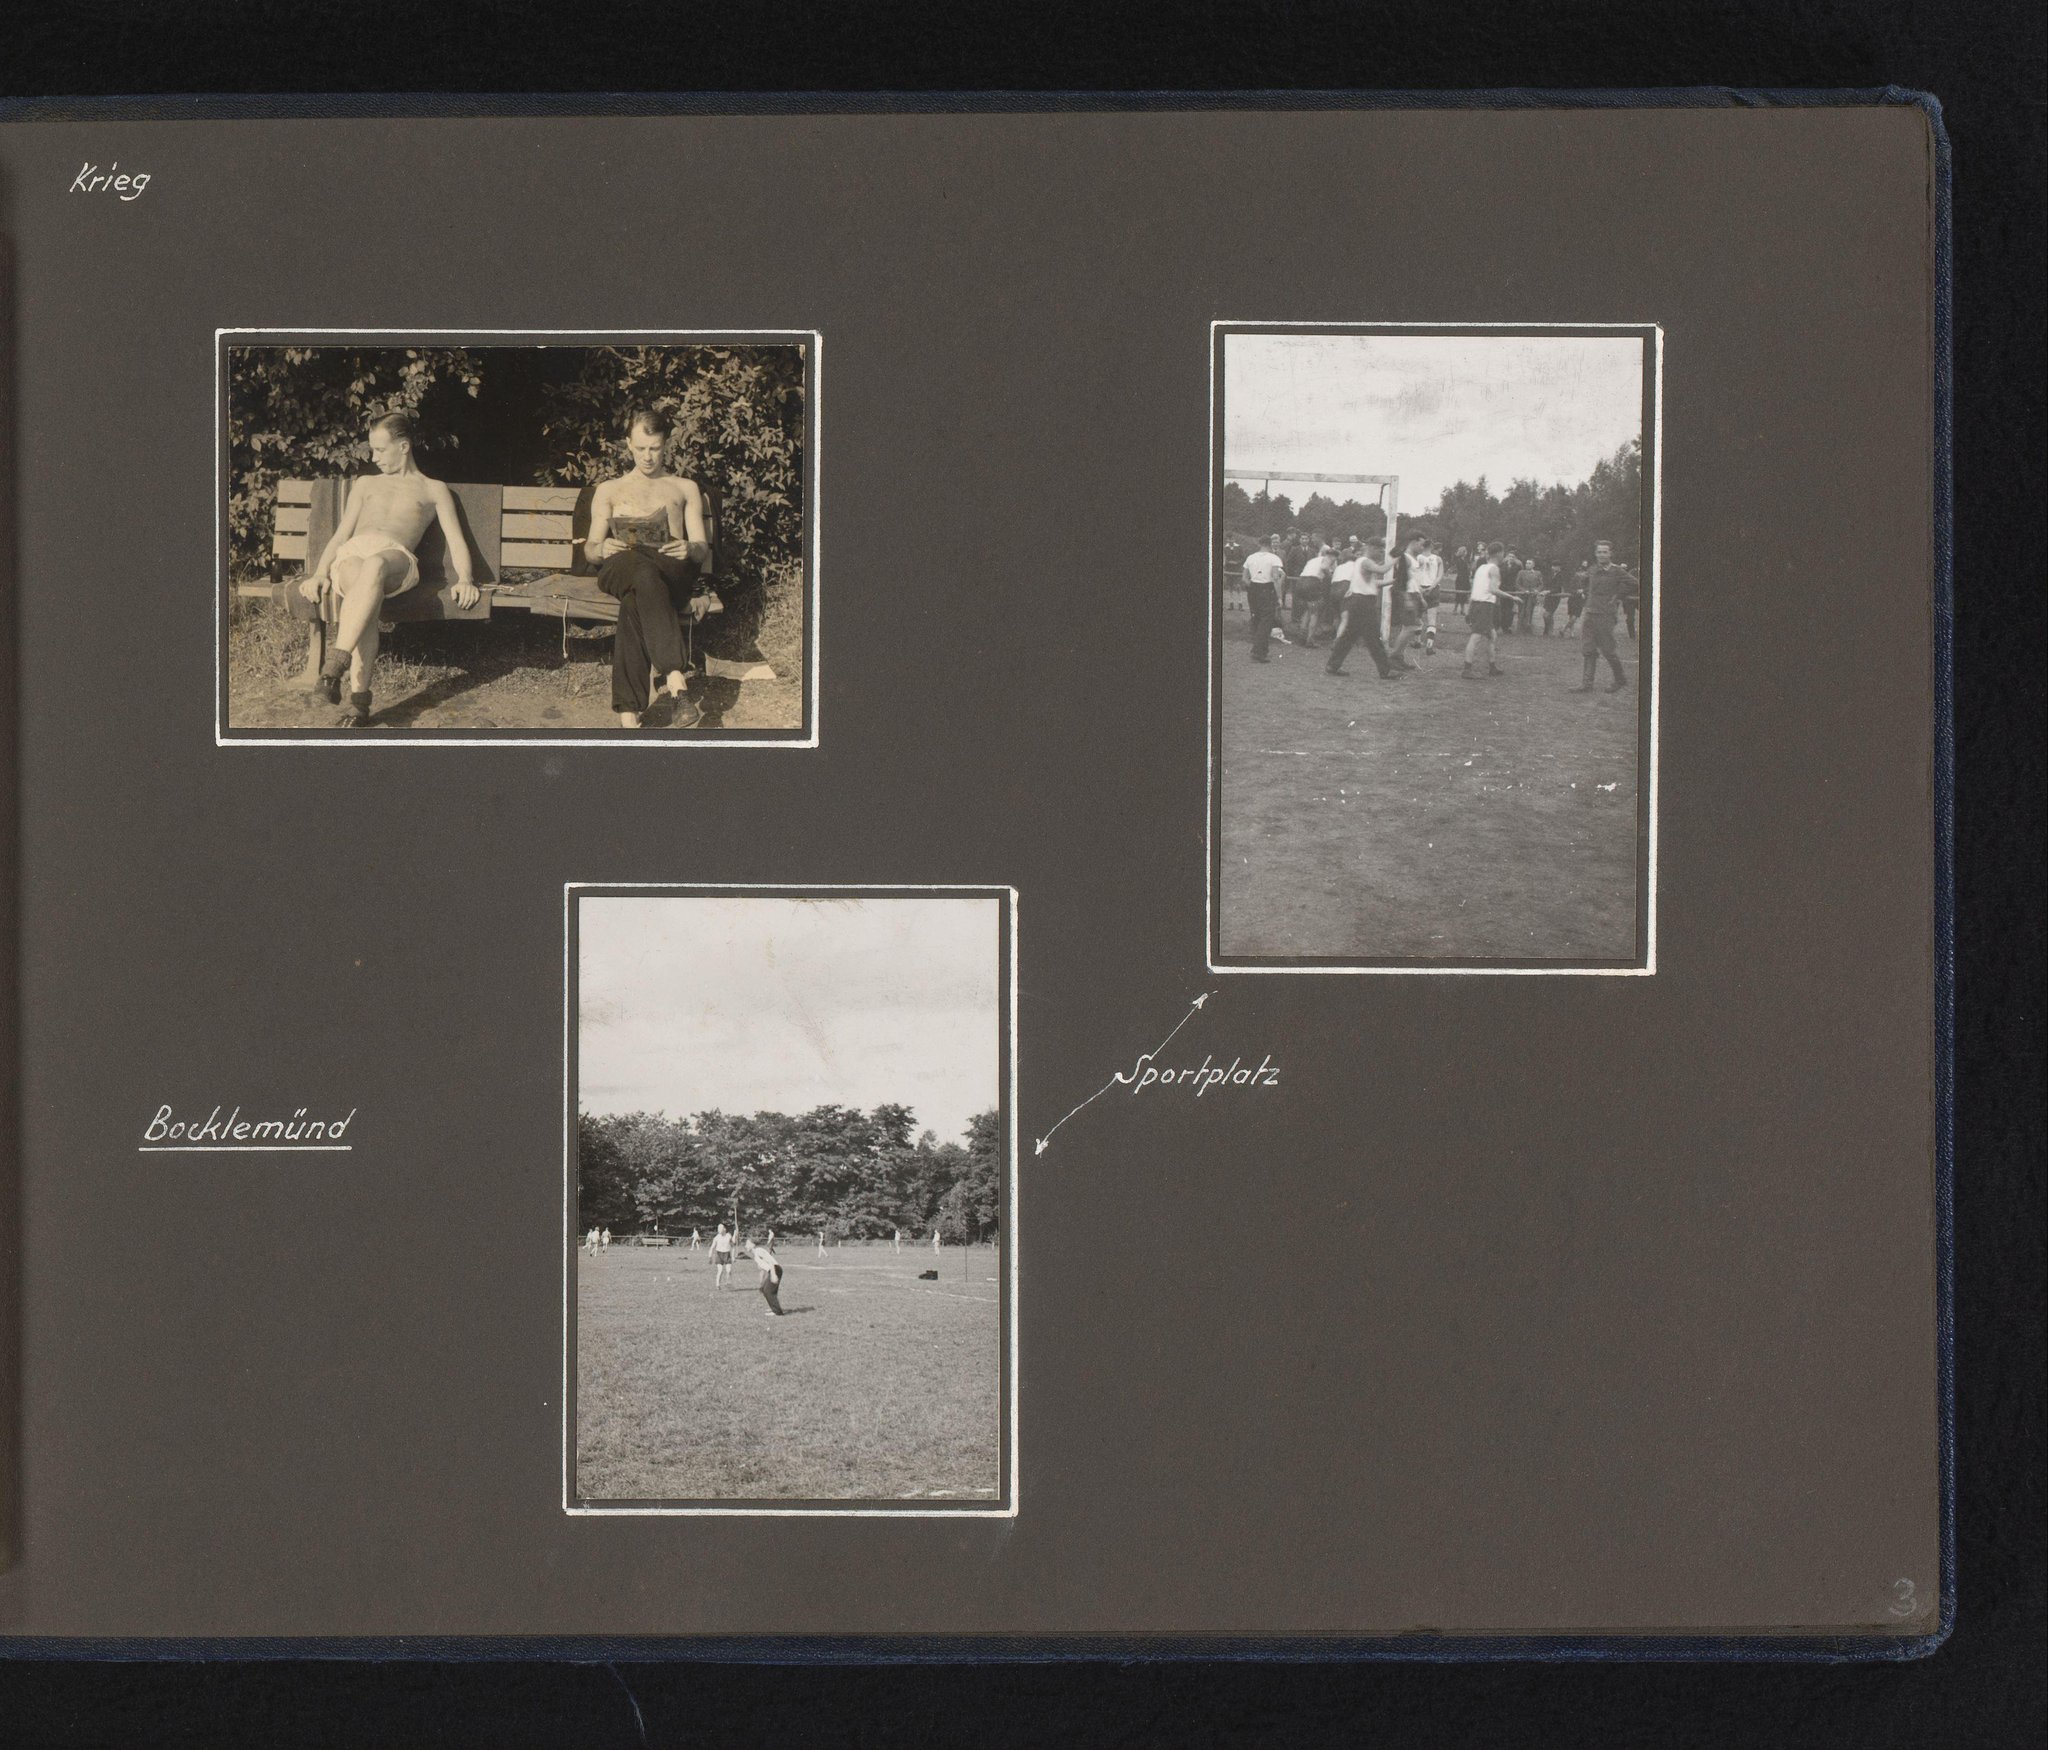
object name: photograph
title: Opleiding in Bocklemünd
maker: Anonymous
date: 1939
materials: paper, photographic support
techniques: gelatin silver print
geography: germany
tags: military training, recreation ~ the soldier off duty, germany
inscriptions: inscription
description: Albumblad gemerkt 'Krieg' met drie foto's tijdens de militaire opleiding in Bocklemünd (Keulen), 1939. Twee zonnende militairen op een boekje en twee foto's van sportende militairen. Onderdeel van een Duits militair album Tweede Wereldoorlog 1939-1940.